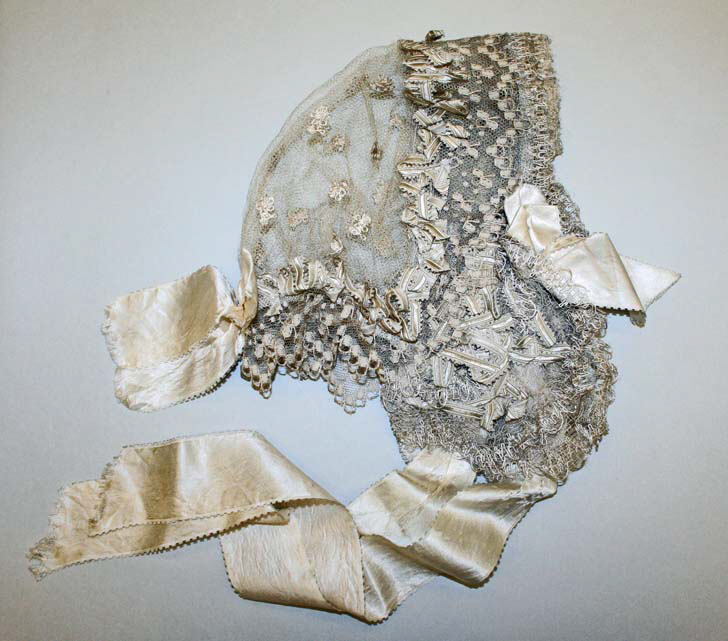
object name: wedding bonnet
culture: british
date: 1850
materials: silk